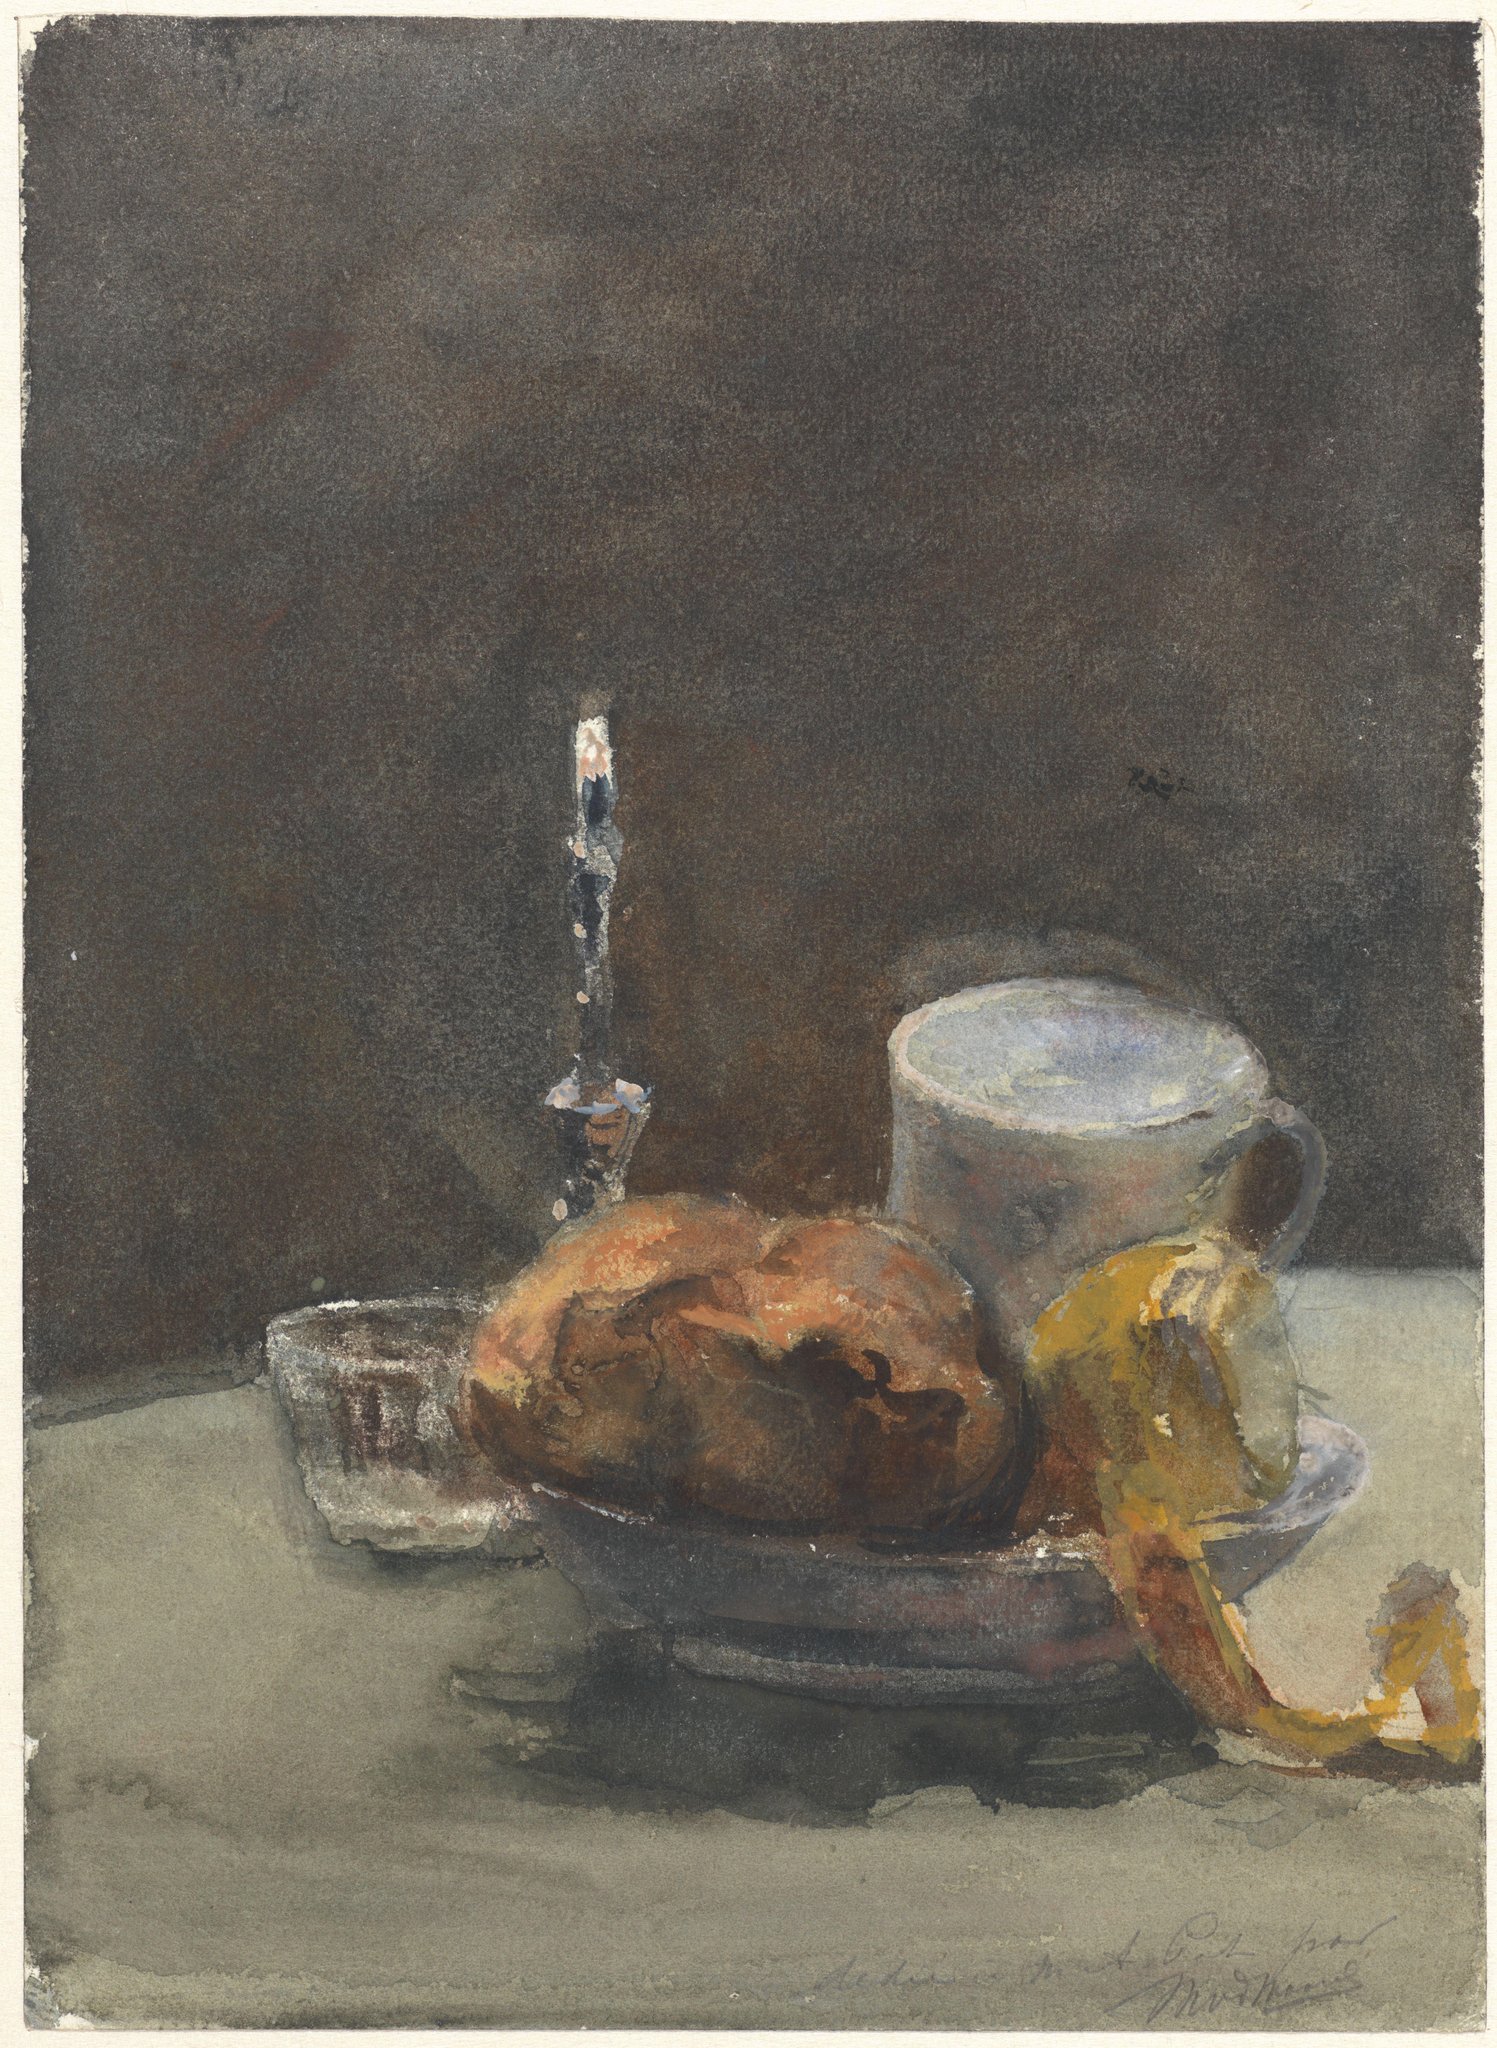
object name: drawing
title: Stilleven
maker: marinus van der maarel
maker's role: draughtsman, painter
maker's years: 1857-1921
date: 1867-1913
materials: paint, paper, watercolor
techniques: brush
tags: still life of miscellaneous objects